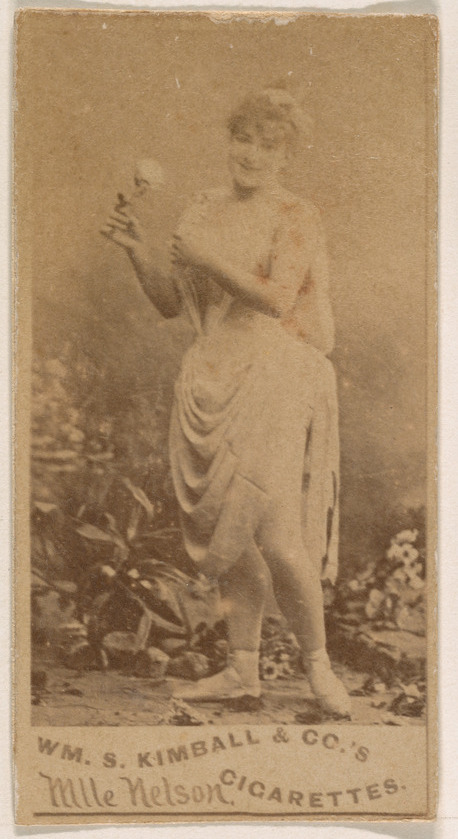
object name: photograph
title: Mlle. Nelson, from the Actresses series (N203) issued by Wm. S. Kimball & Co.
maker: william s. kimball & company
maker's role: publisher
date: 1889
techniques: color lithograph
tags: portraits,women,actresses